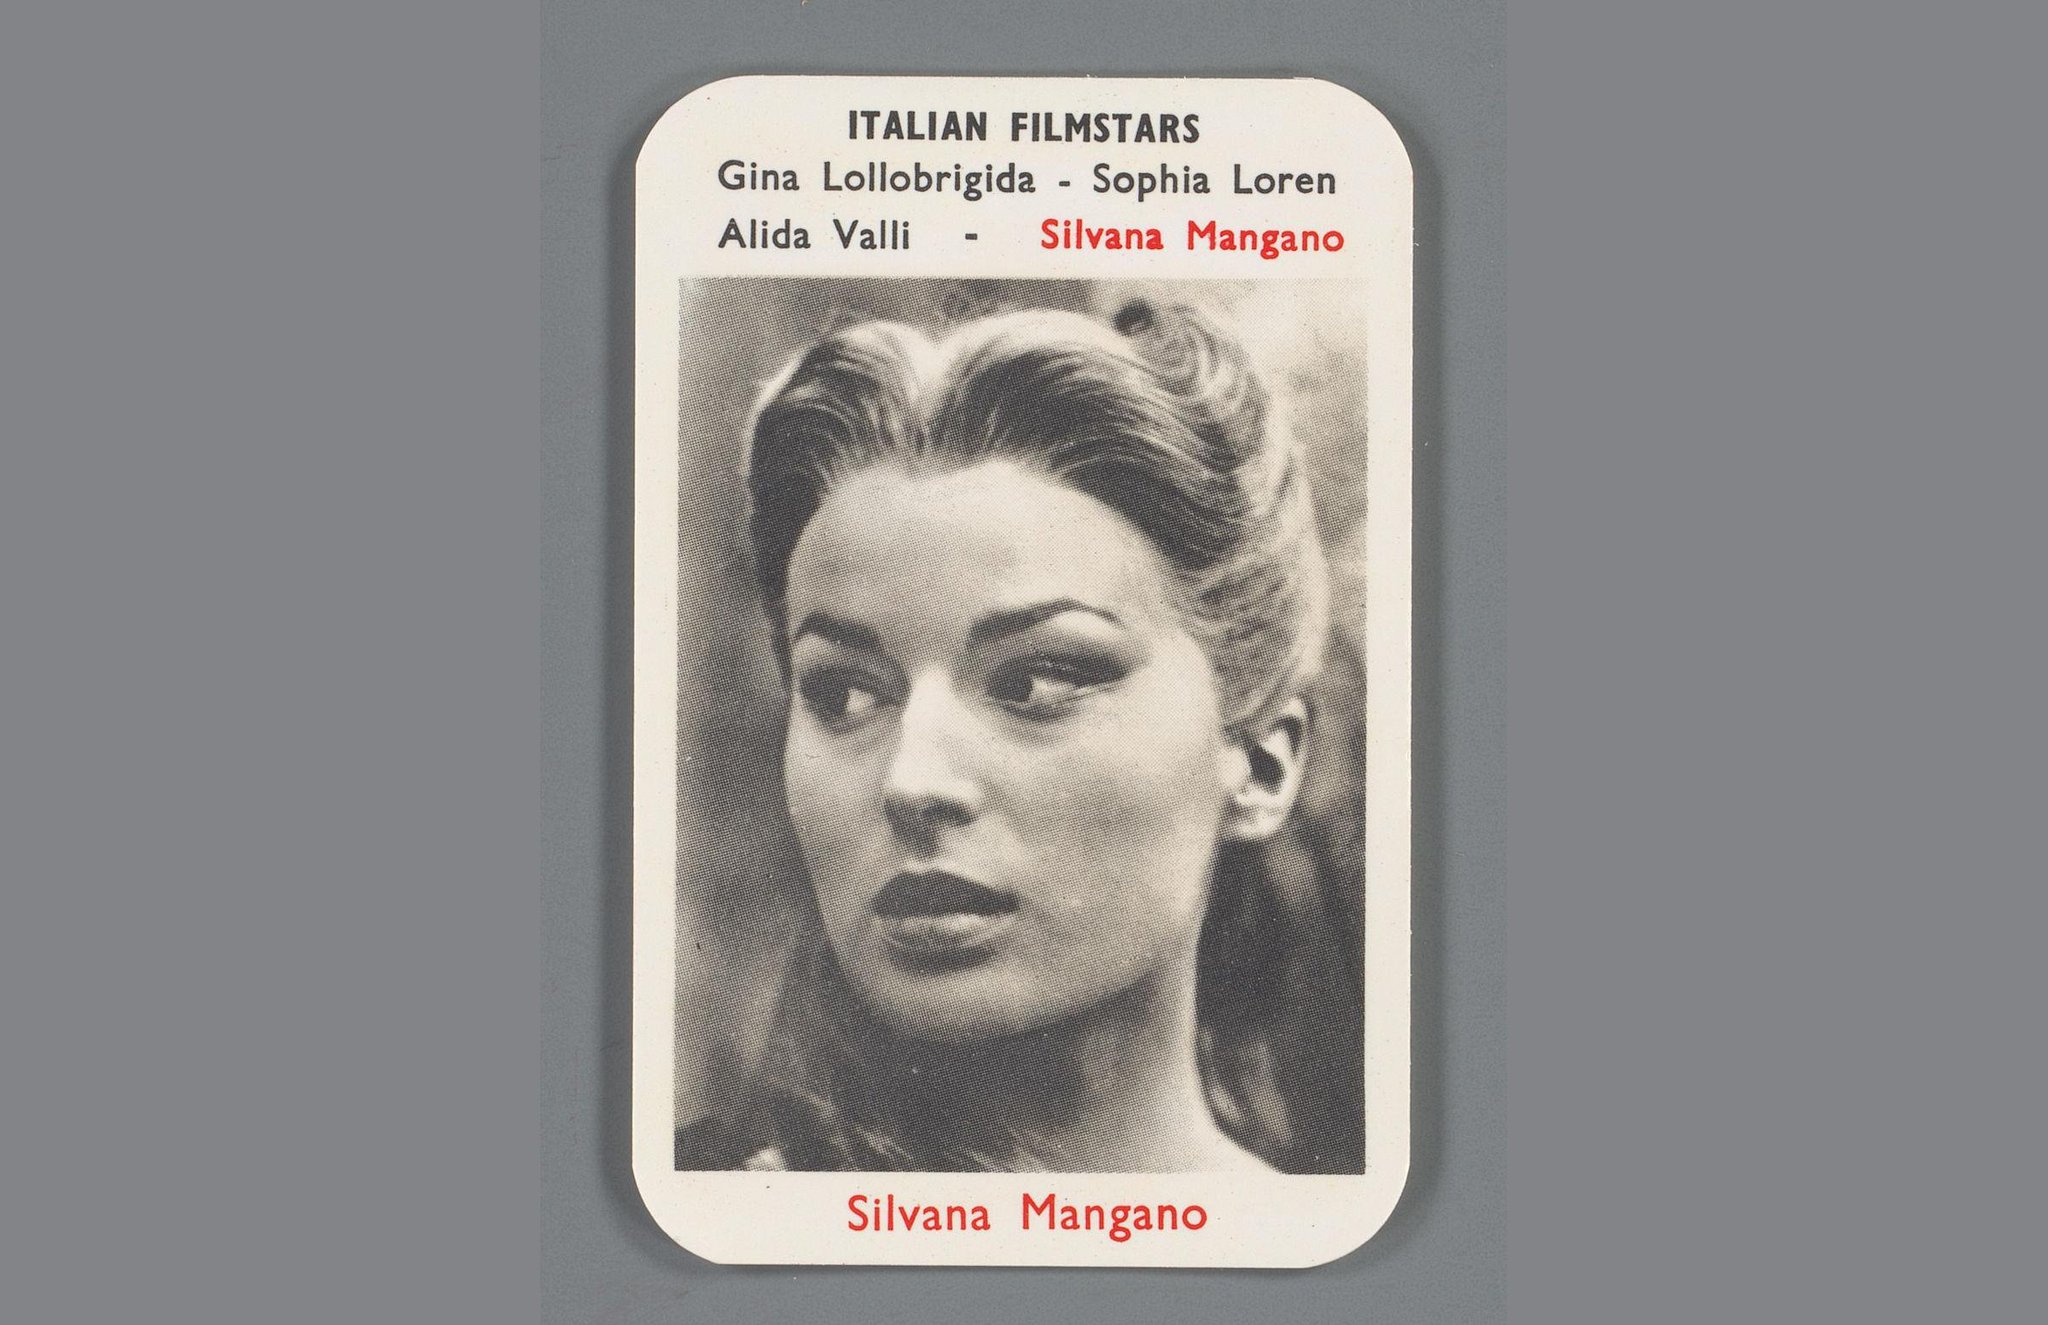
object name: photomechanical print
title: Portret van Silvana Mangano; onderdeel van het kwartet Italian Filmstars uit een kwartetspel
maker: Anonymous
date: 1960-1970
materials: paper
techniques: autotype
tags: portrait of actor, actress